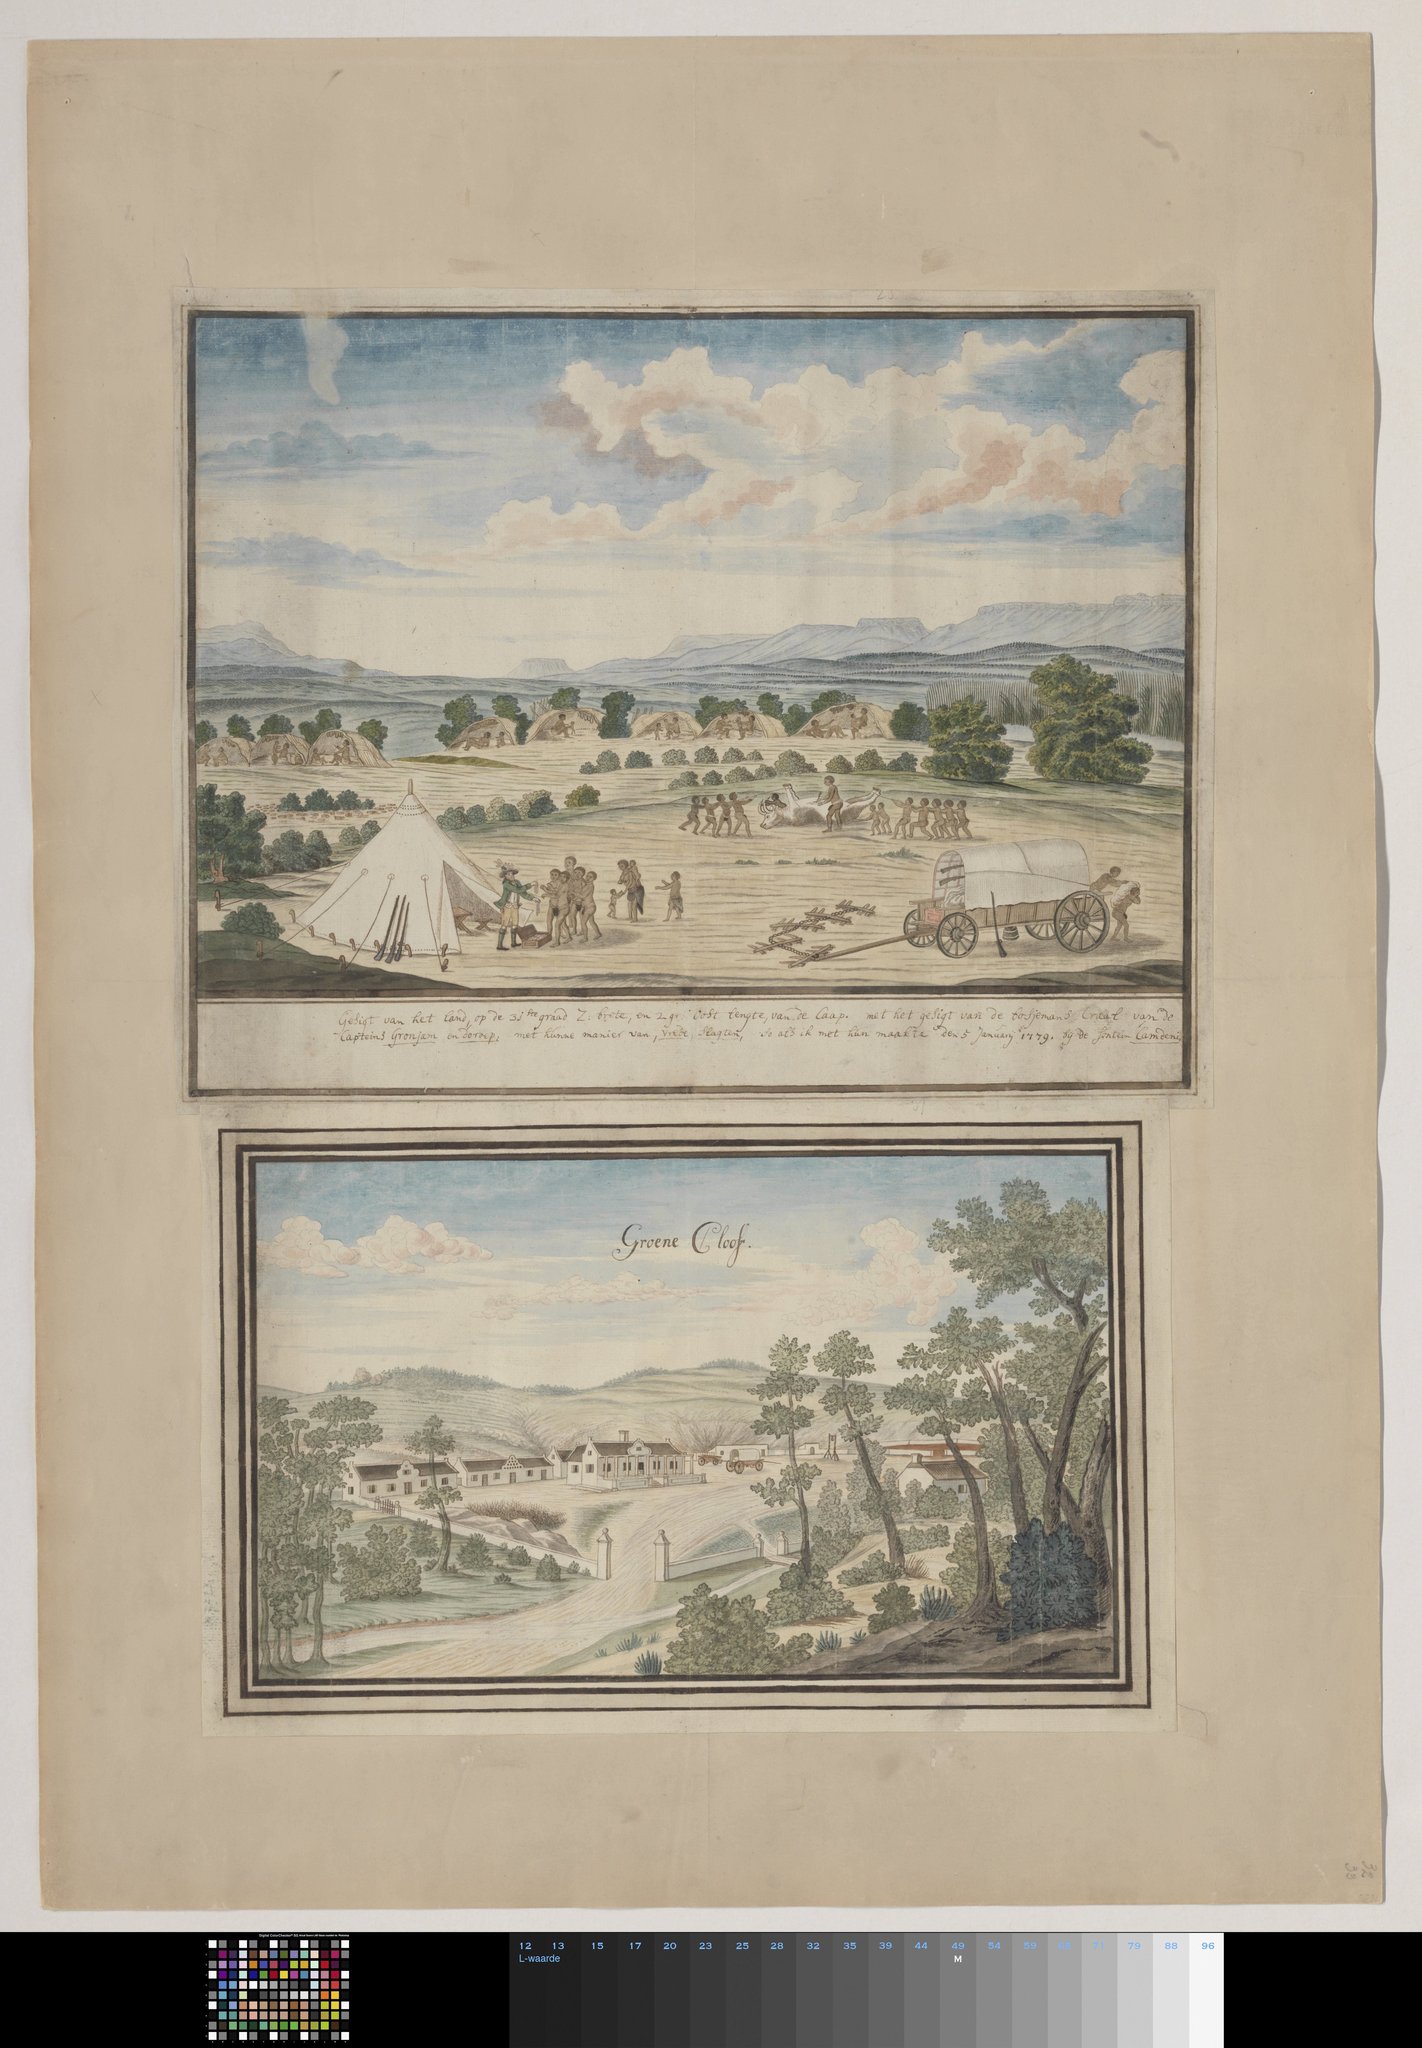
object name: drawing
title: View of the Dutch East India Company’s cattle-post Groenkloof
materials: ink, paper, pencil, watercolor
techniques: brush, pen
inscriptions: annotation: ‘Groene Cloof’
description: Oorspronkelijk in omslag van roodkleurig halfleer en roodgemarmerd plat, dorso met ribben en goudopdruk; 71 x 99 x 6 cm.